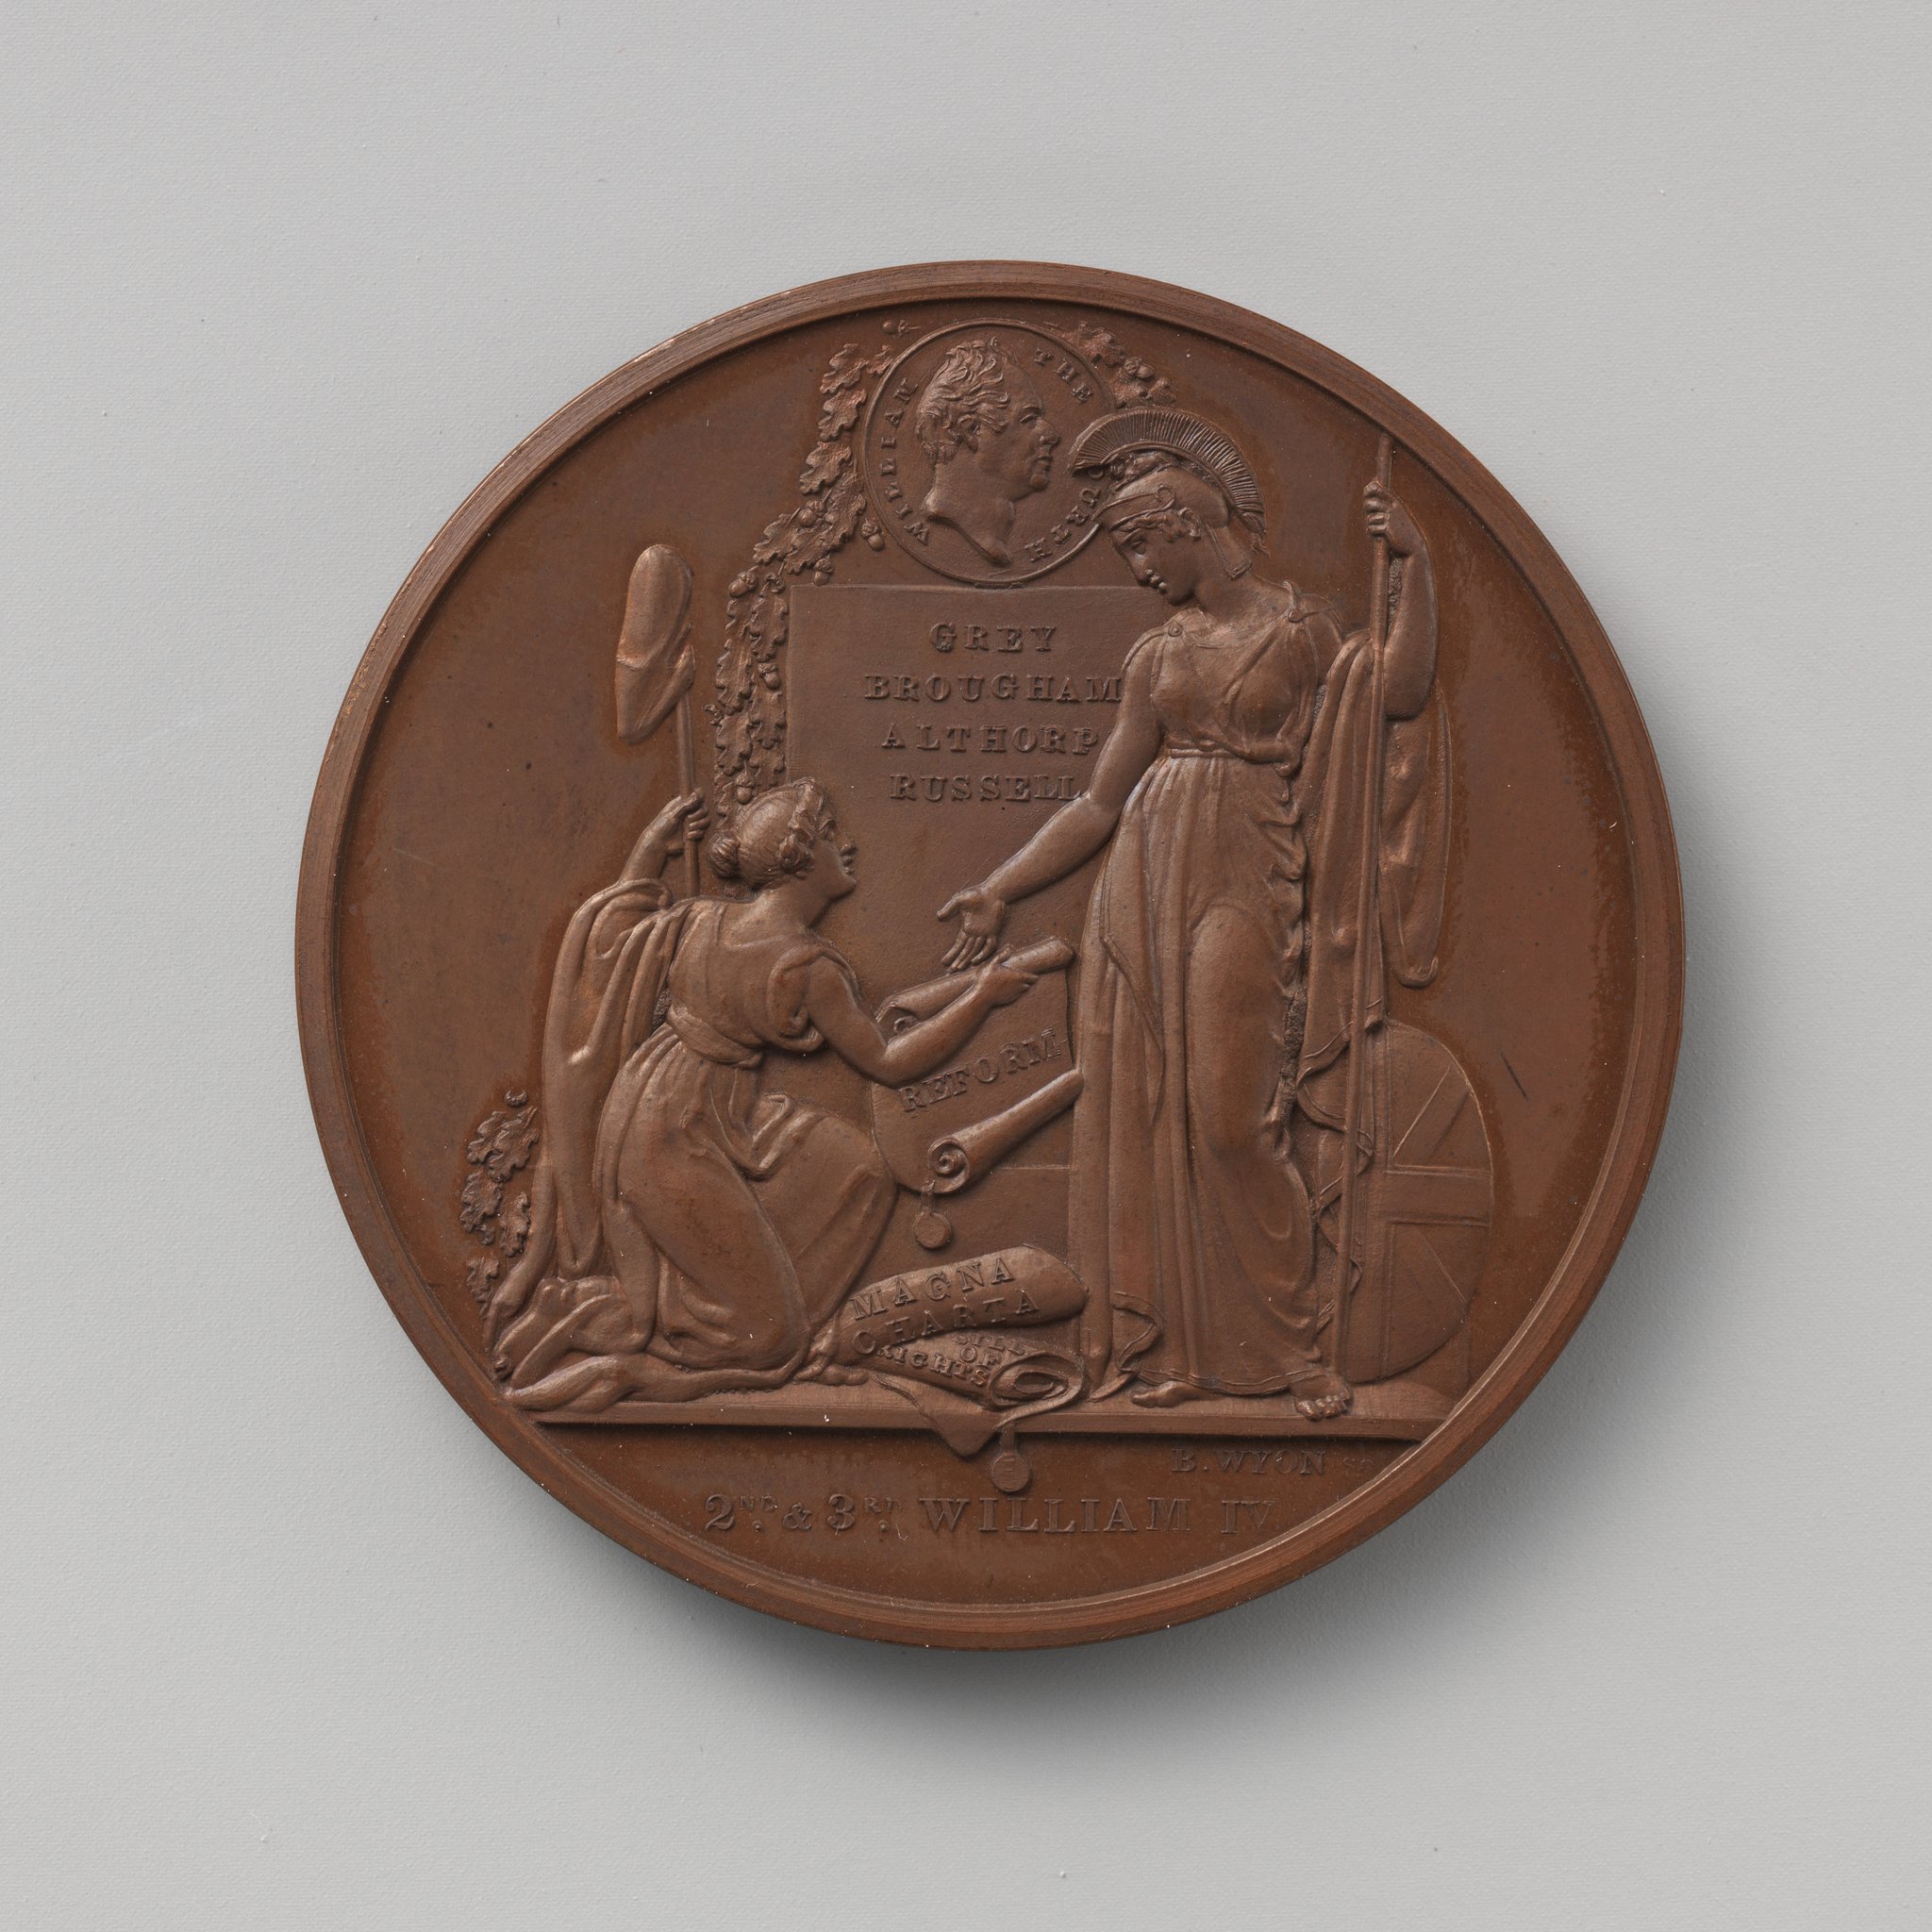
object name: medal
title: A Whig Medal, evidently issued by the city, to Commemorate the Passage of the 2nd Reform Bill, 1832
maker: benjamin wyon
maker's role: artist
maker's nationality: british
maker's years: 1802-1858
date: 1832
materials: bronze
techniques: struck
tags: men,profiles,women